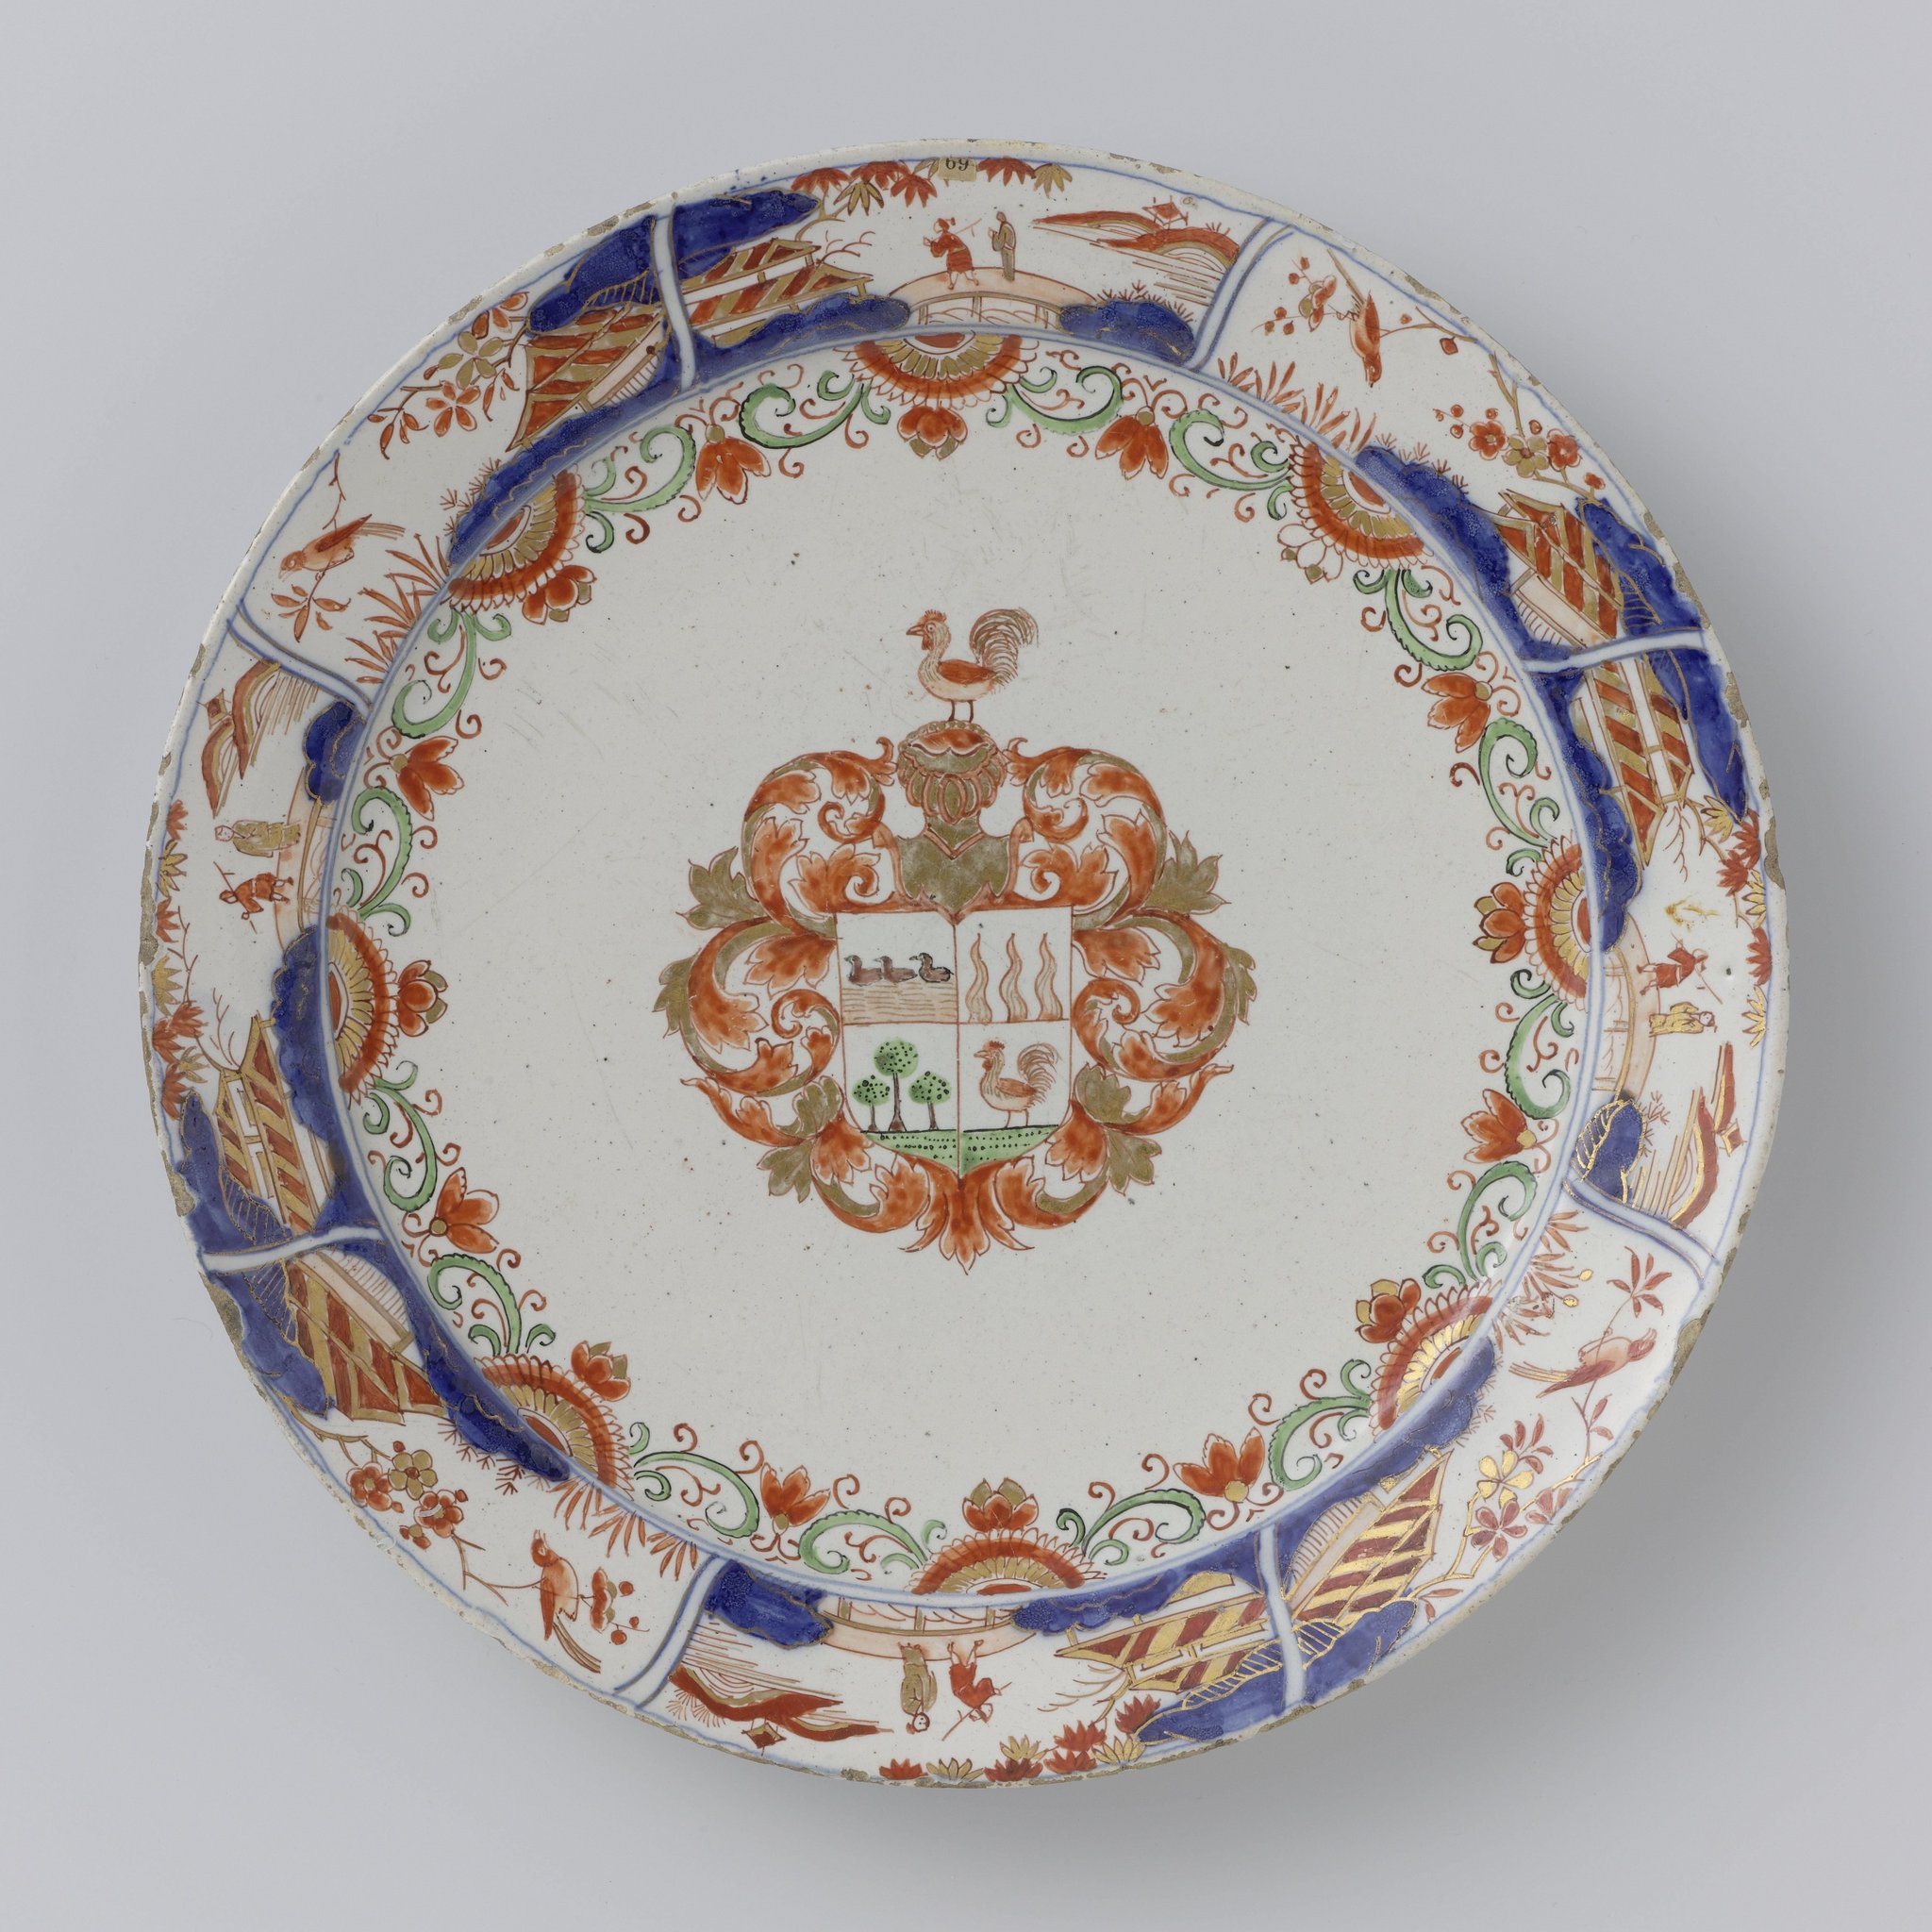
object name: plate dish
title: Bord van faïence met wapen Van Beuningen - Van Leeuwen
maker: Anonymous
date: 1700-1725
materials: earthenware, glaze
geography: delft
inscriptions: inscription: ‘67’, collector's mark: ‘collection loudon’, inscription: ‘69’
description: Bord van faïence, in Imari kleuren met in het midden het alliantiewapen van Jan van Beuningen (1667-1720) en Catharina Constantina van Leeuwen (1675-1720).